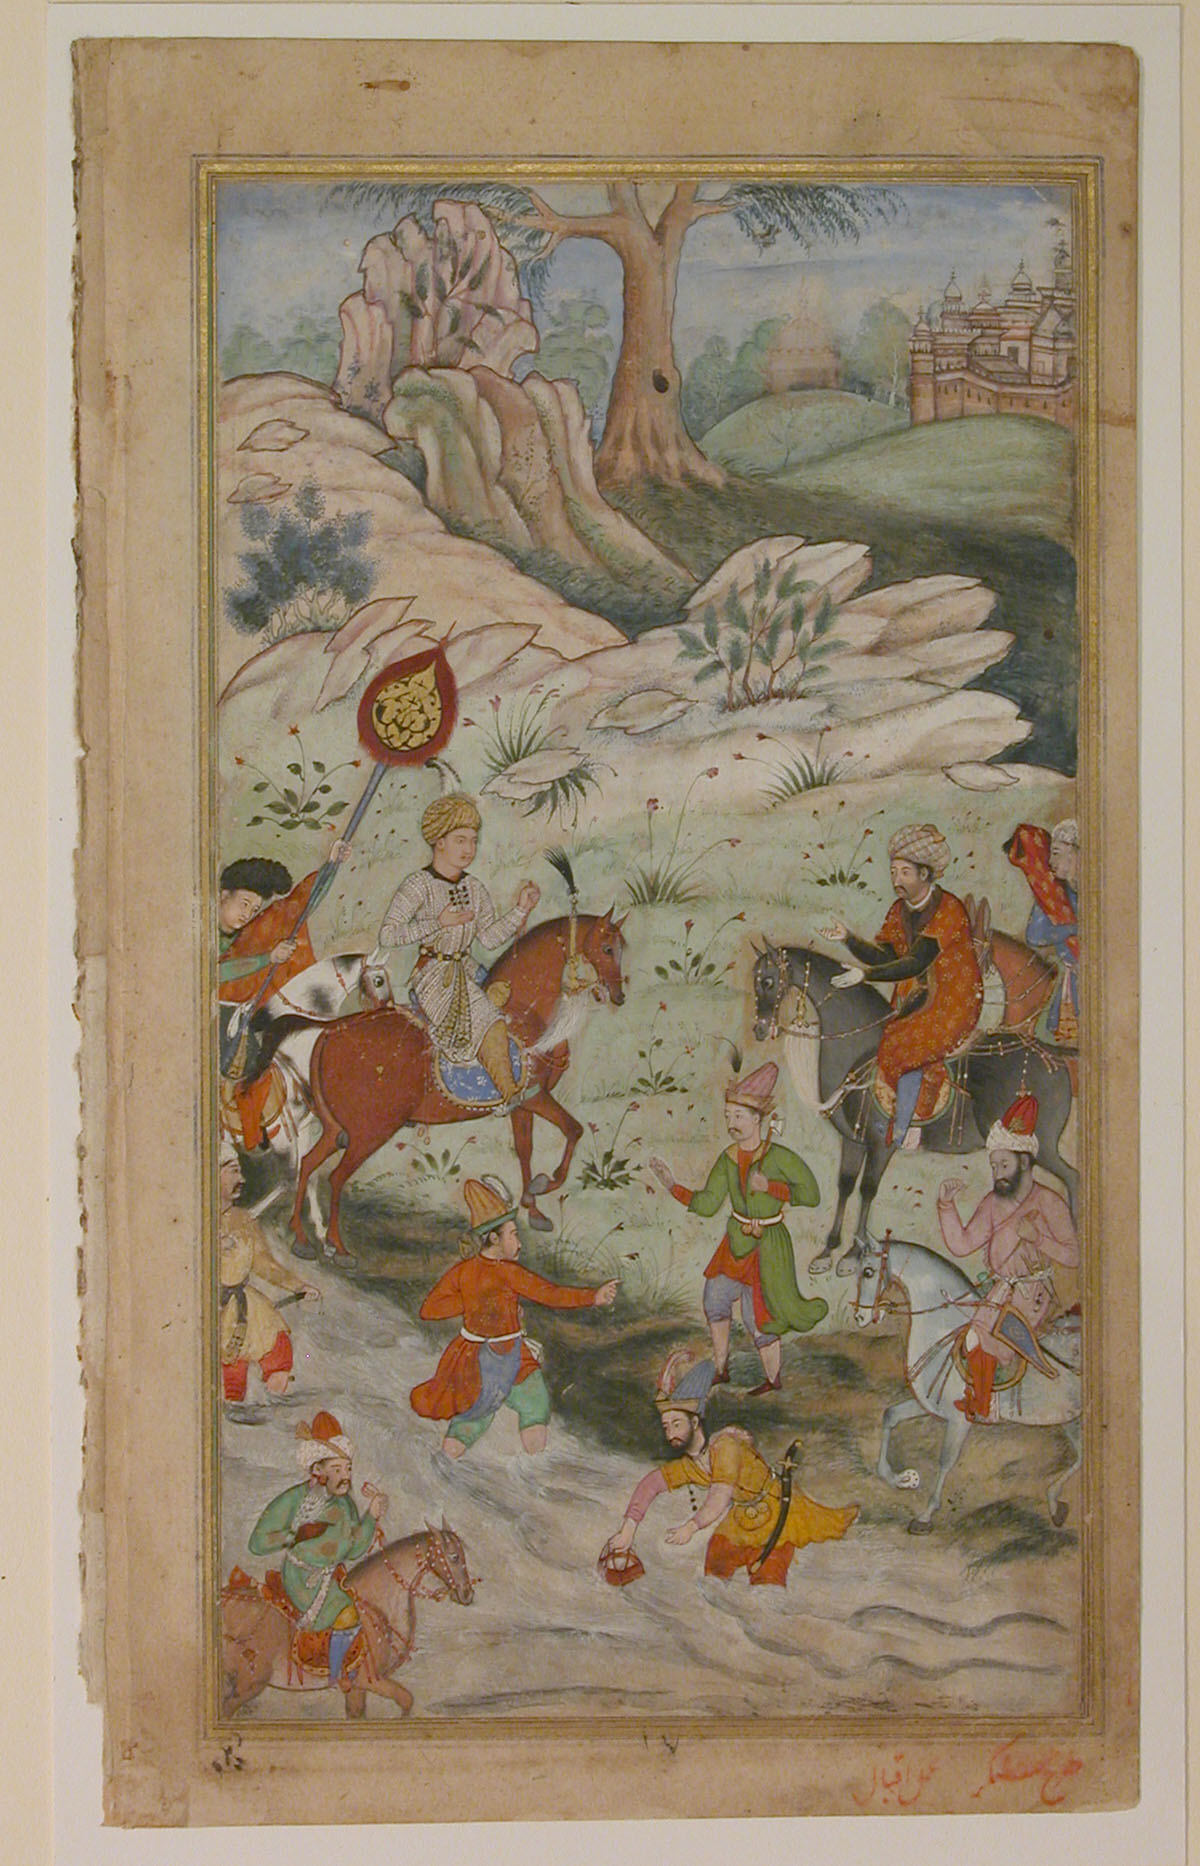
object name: folio from an illustrated manuscript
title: "Meeting between Babur and Sultan 'Ali Mirza near Samarqand", Folio from a Baburnama (The Book of Babur)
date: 1590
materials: gold, ink, paper, watercolor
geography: pakistan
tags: men,horses